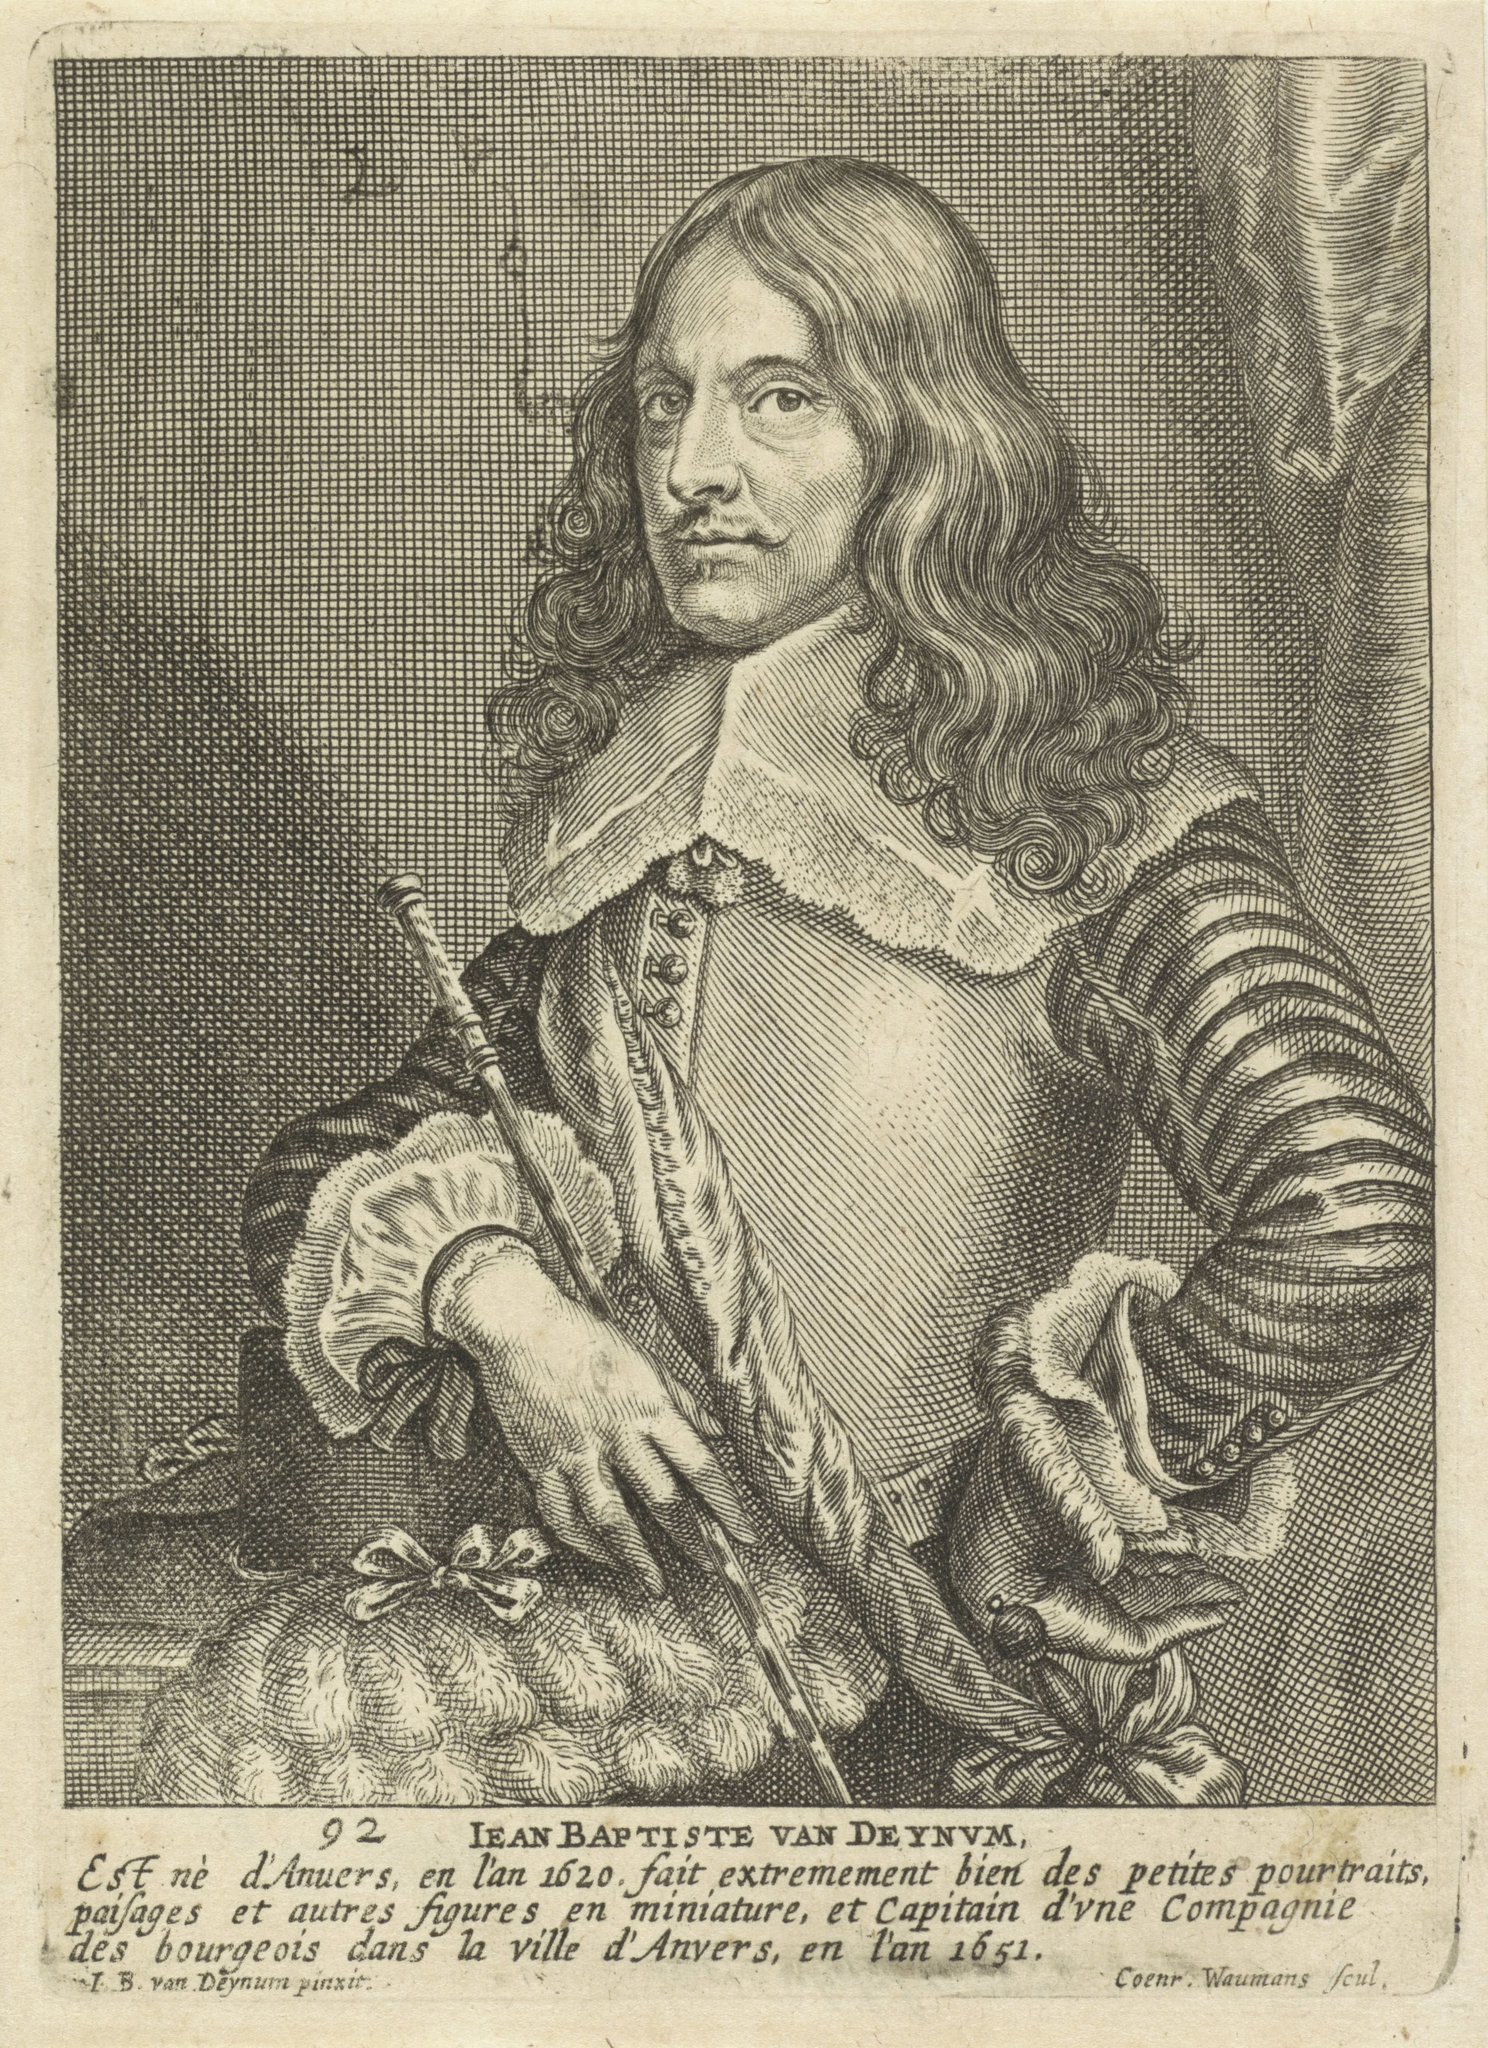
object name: print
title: Portret van de schilder Jan Baptist van Deynum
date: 1694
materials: paper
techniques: engraving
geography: antwerp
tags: antwerp, jan baptist van deynum, portrait, self-portrait of painter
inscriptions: collector's mark: Lugt 2228, inscription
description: Prent gebruikt in: The true effigies of the most emminent painters and other famous artists that have flourished in Europe curiously engraven on 125 copper plates. Antwerpen: J. Meyssens, 1694.